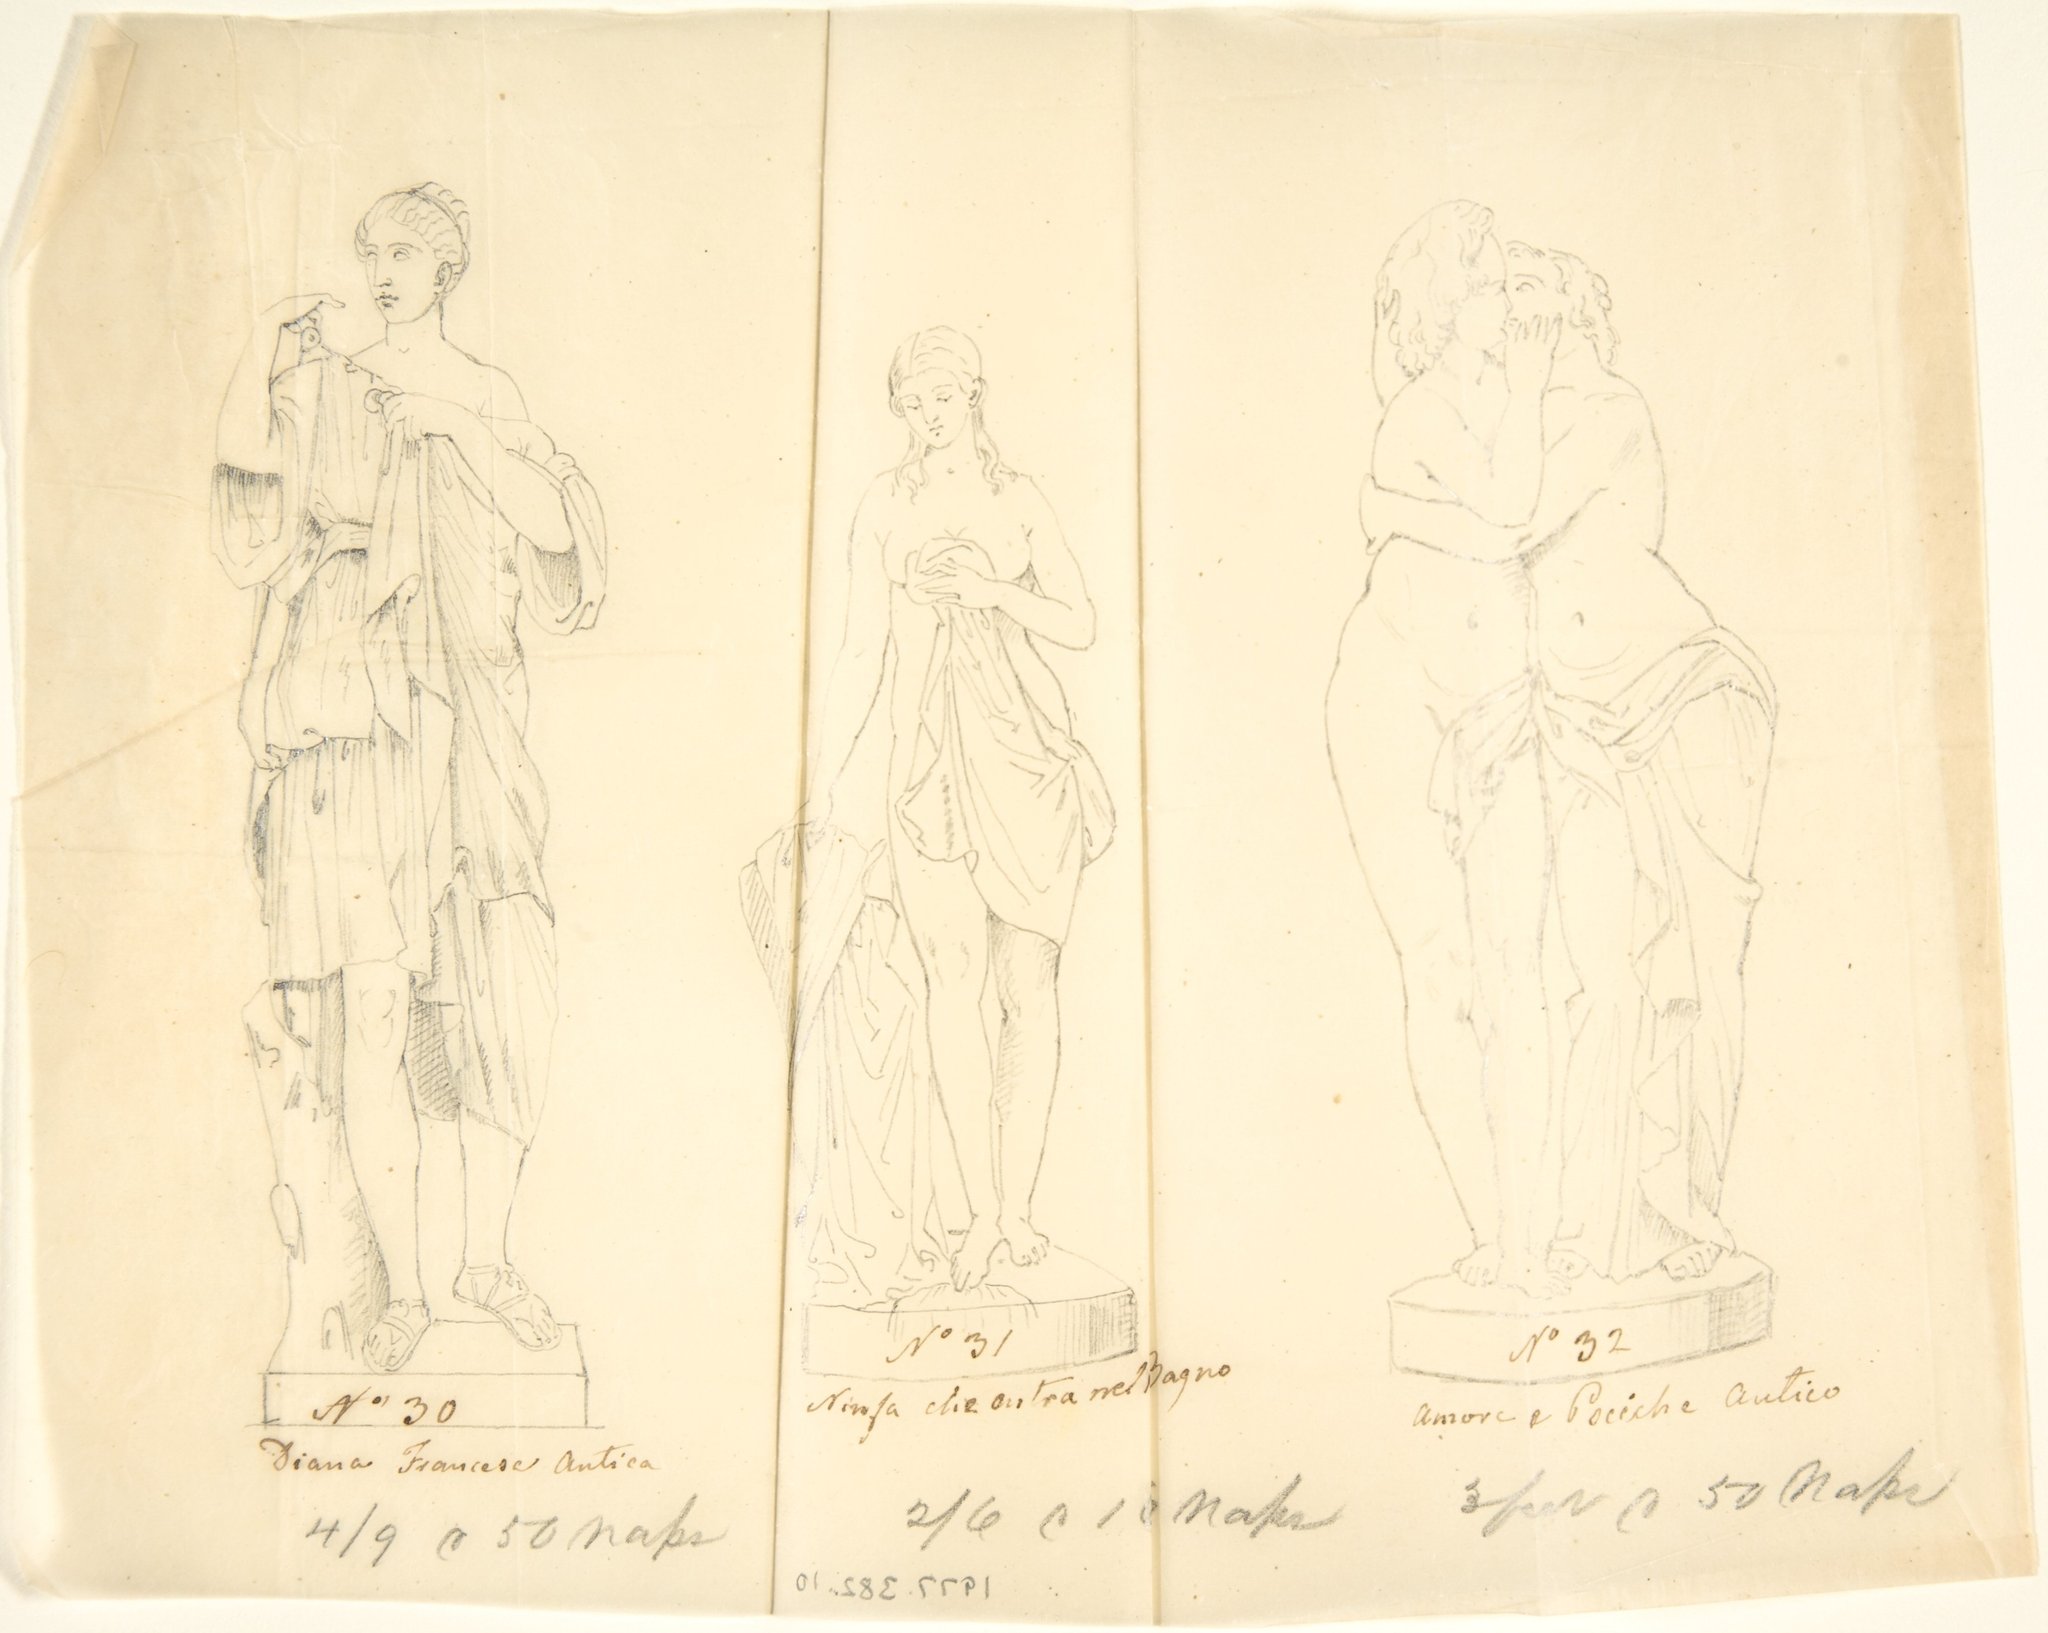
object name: drawing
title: Sketches of three statues: Diana, Nymph Bathing and Cupid and Pysche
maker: john gibson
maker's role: artist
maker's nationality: british, born wales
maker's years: 1790-1866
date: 1850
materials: graphite, ink, paper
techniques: pen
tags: cupid,psyche,nymphs,diana